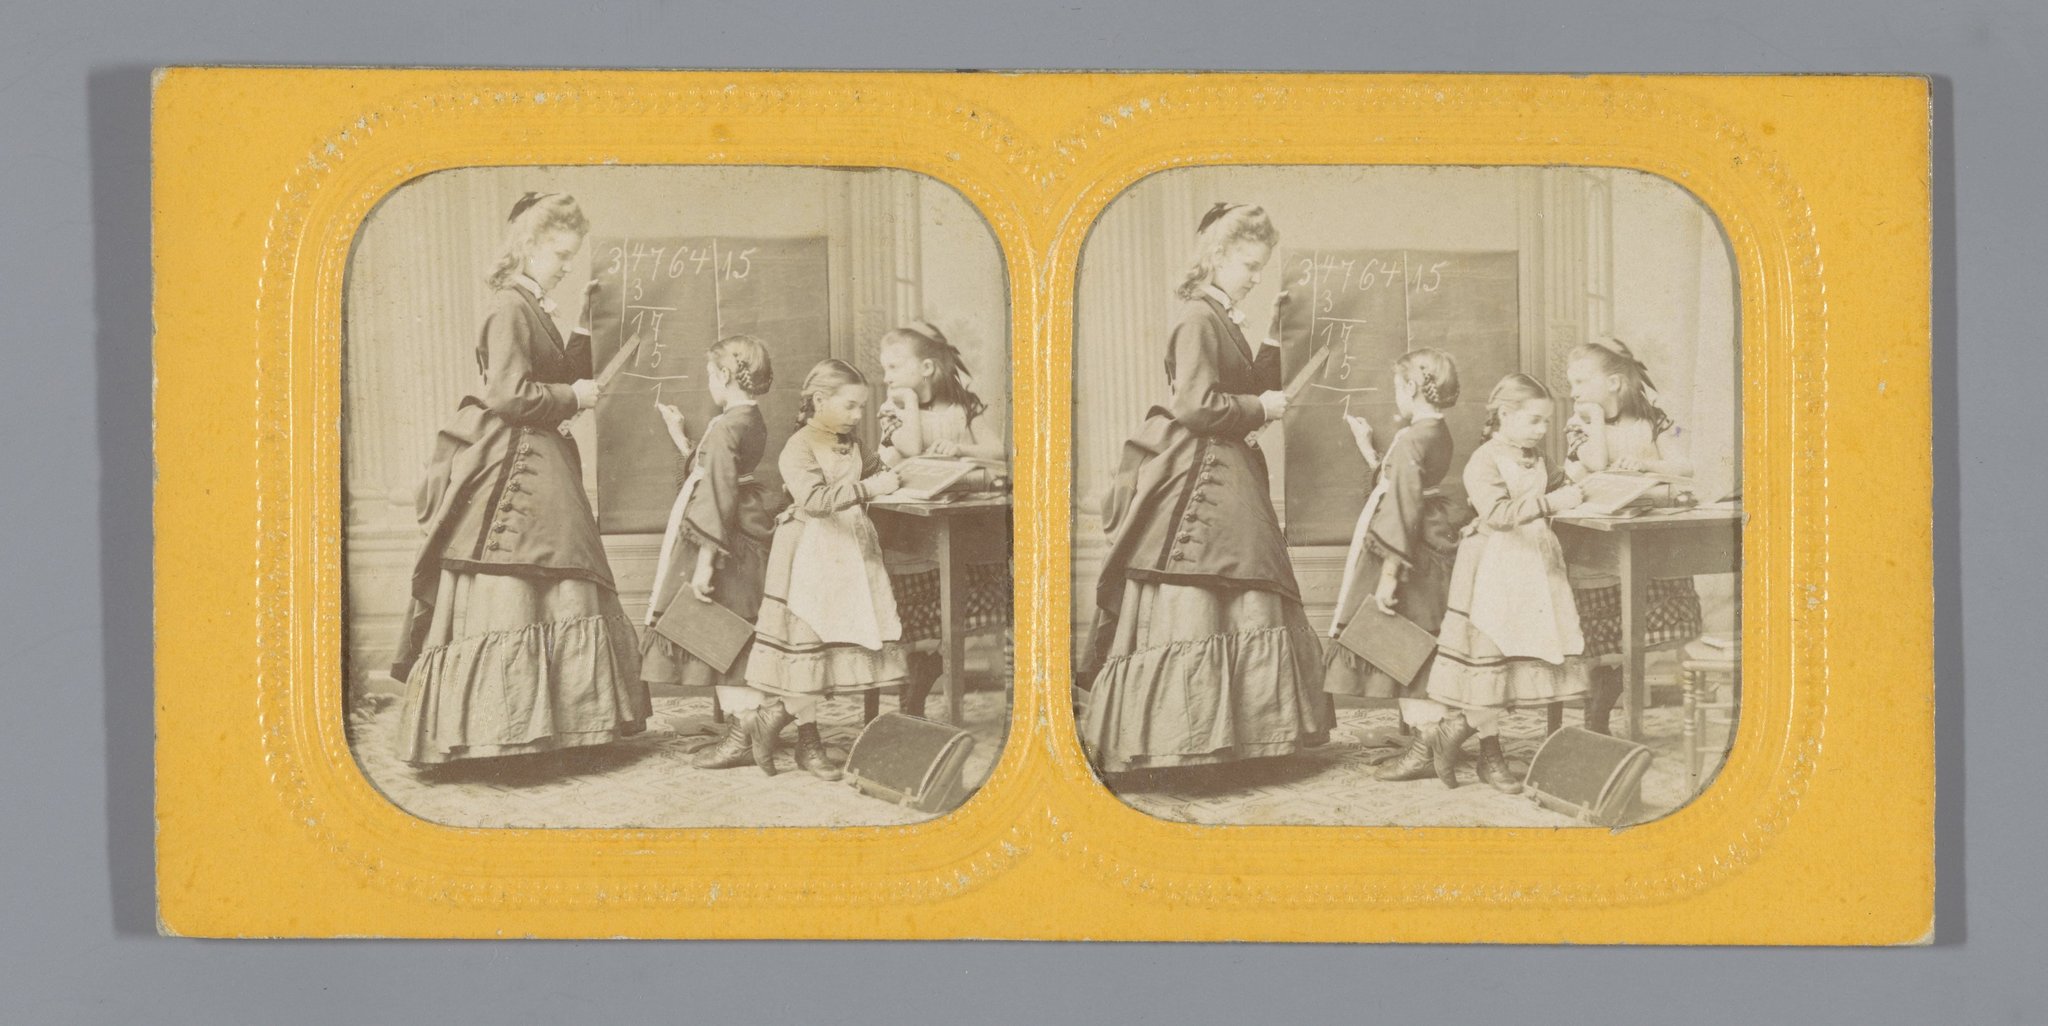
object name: tissue stereograph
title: Lerares met drie meisjes in schoolklas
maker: sophus williams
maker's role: publisher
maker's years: 1835-1900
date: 1879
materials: cardboard, paper, photographic support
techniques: albumen print, cutting, hand coloring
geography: berlin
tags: elementary school; class, form